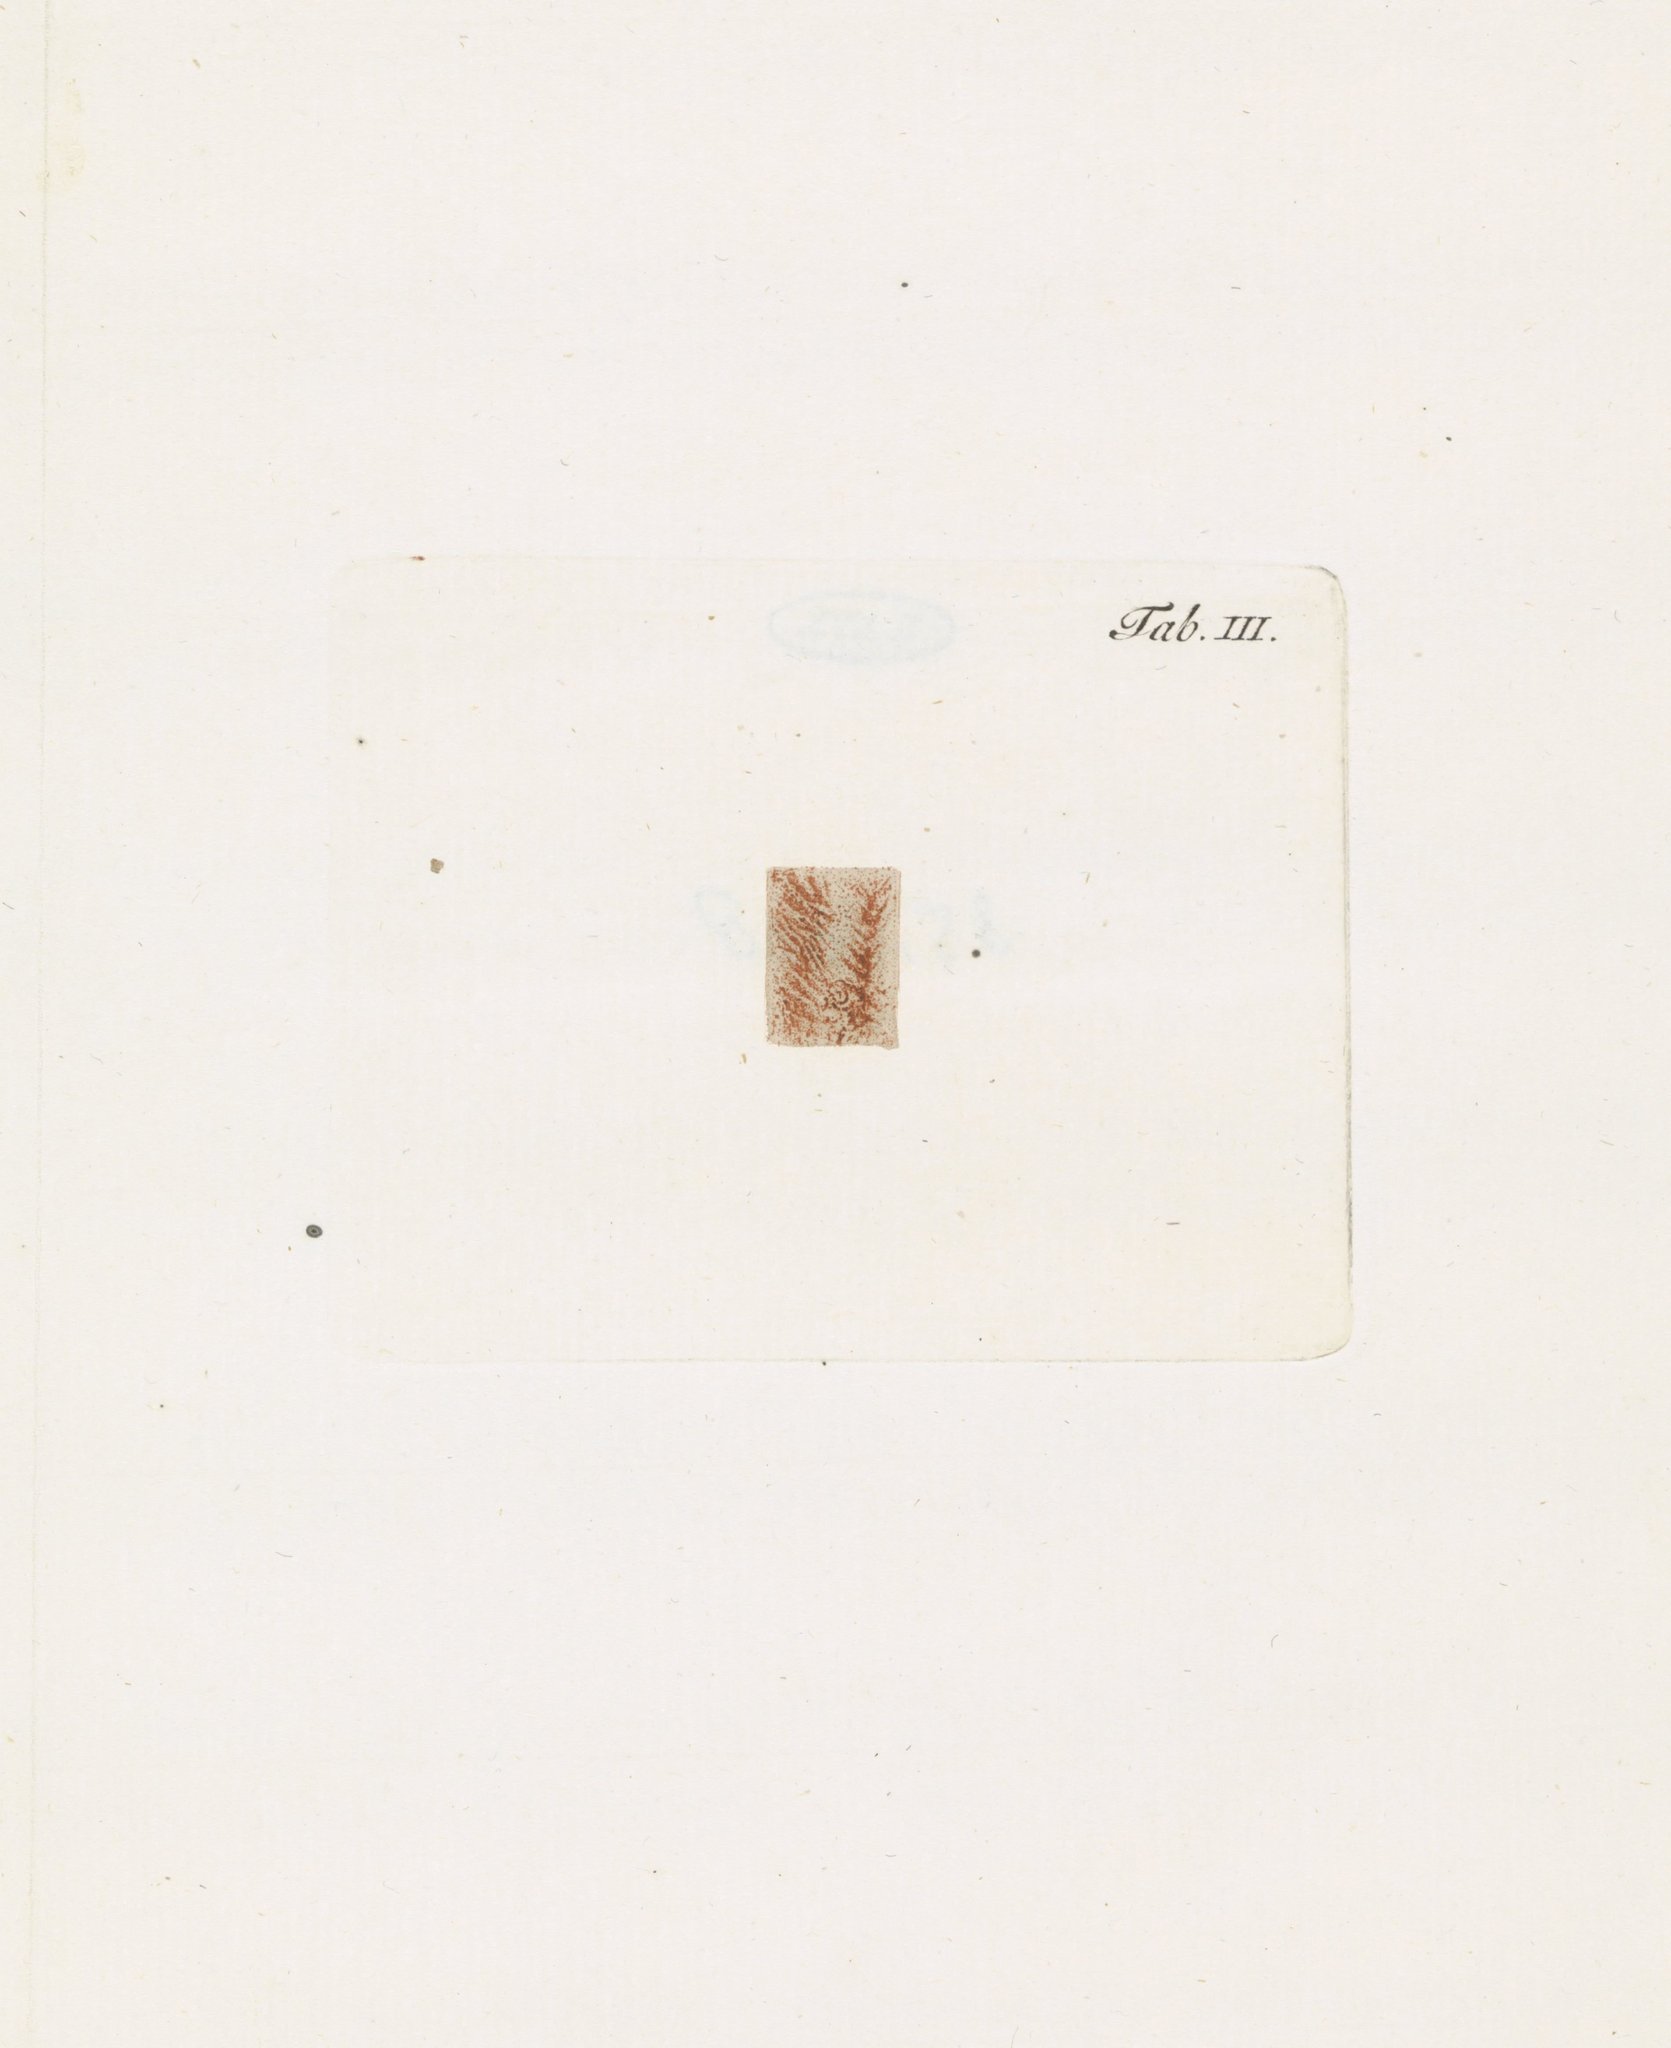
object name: print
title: Anatomische afbeelding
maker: robbert muys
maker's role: print maker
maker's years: 1742-1825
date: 1785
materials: ink, paper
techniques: brush, etching, pen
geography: rotterdam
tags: physiology and anatomy (+ scientific research)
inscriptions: collector's mark: Lugt 2760, collector's mark: Lugt 2228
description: Prent uit: Bleuland, Janus. Observationes anatomico-medicæ de sana et morbosa oesophagi structura. Leiden: Abraham en Jan Honkoop, 1785.